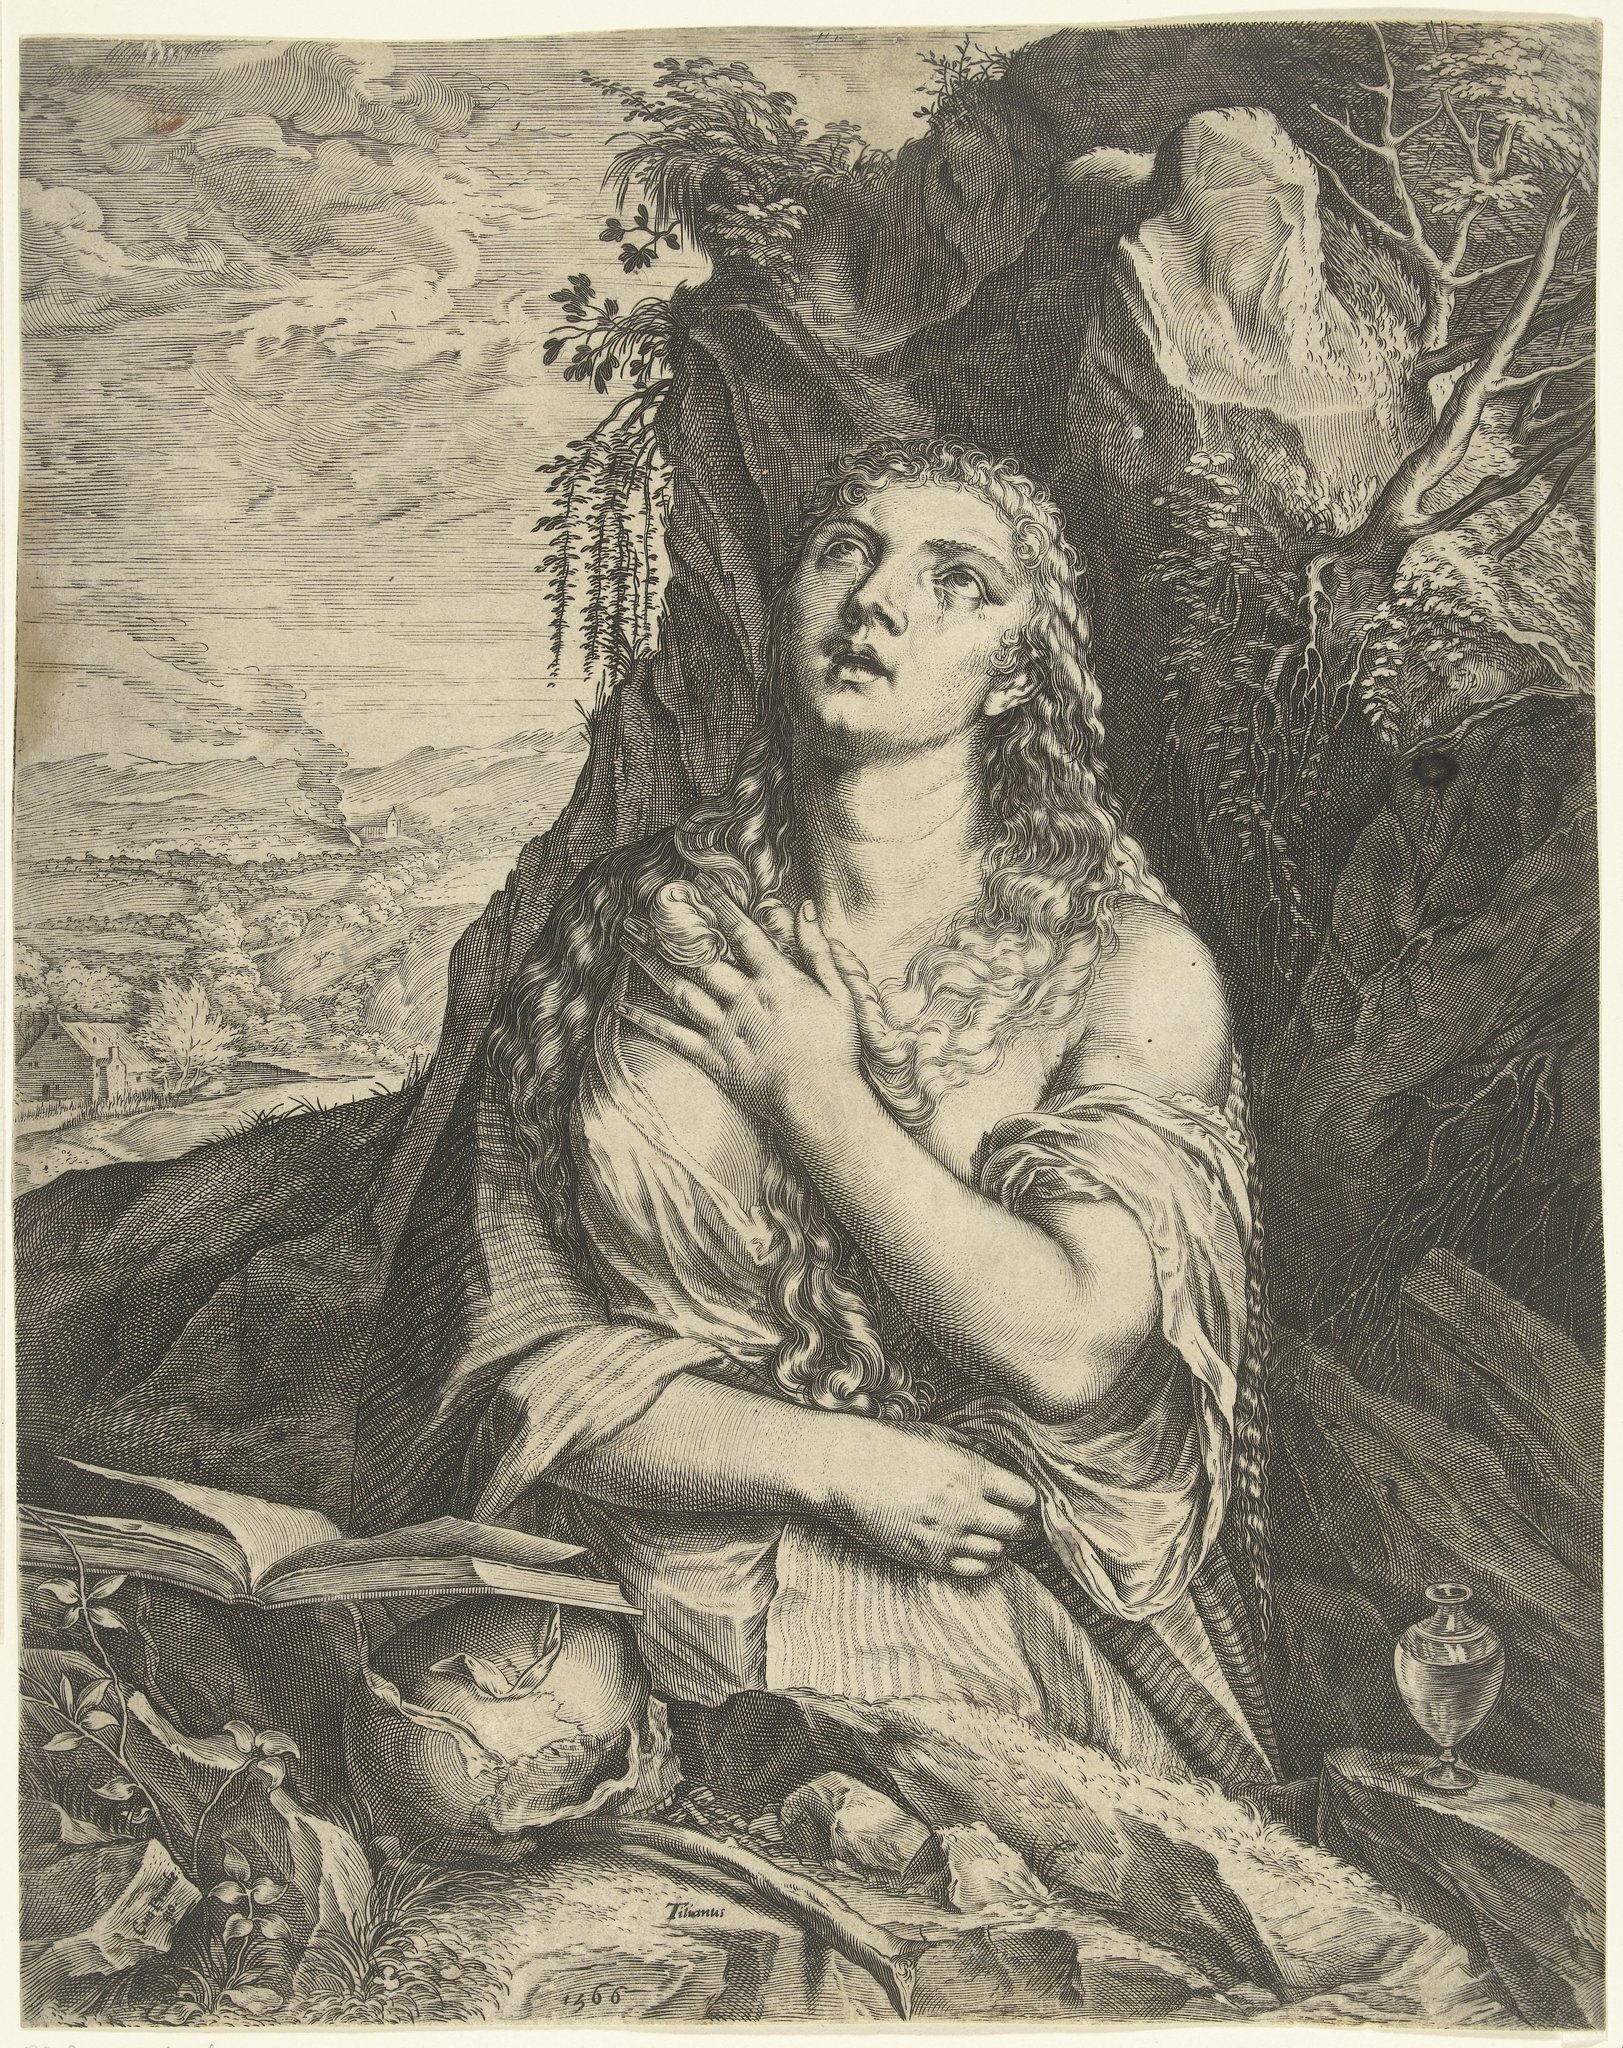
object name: print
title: De boetvaardige Maria Magdalena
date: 1566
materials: paper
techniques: engraving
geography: rome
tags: the penitent harlot mary magdalene; possible attributes: book (or scroll), crown, crown of thorns, crucifix, jar of ointment, mirror, musical instrument, palm-branch, rosary, scourge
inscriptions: collector's mark: Lugt 240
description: Maria Magdalena bidt op een afgelegen plek bij een grot. Ze slaat haar ogen naar de hemel en houdt een hand voor de borst. Naast haar het zalfpotje waarmee ze de voeten van Christus heeft gezalfd.